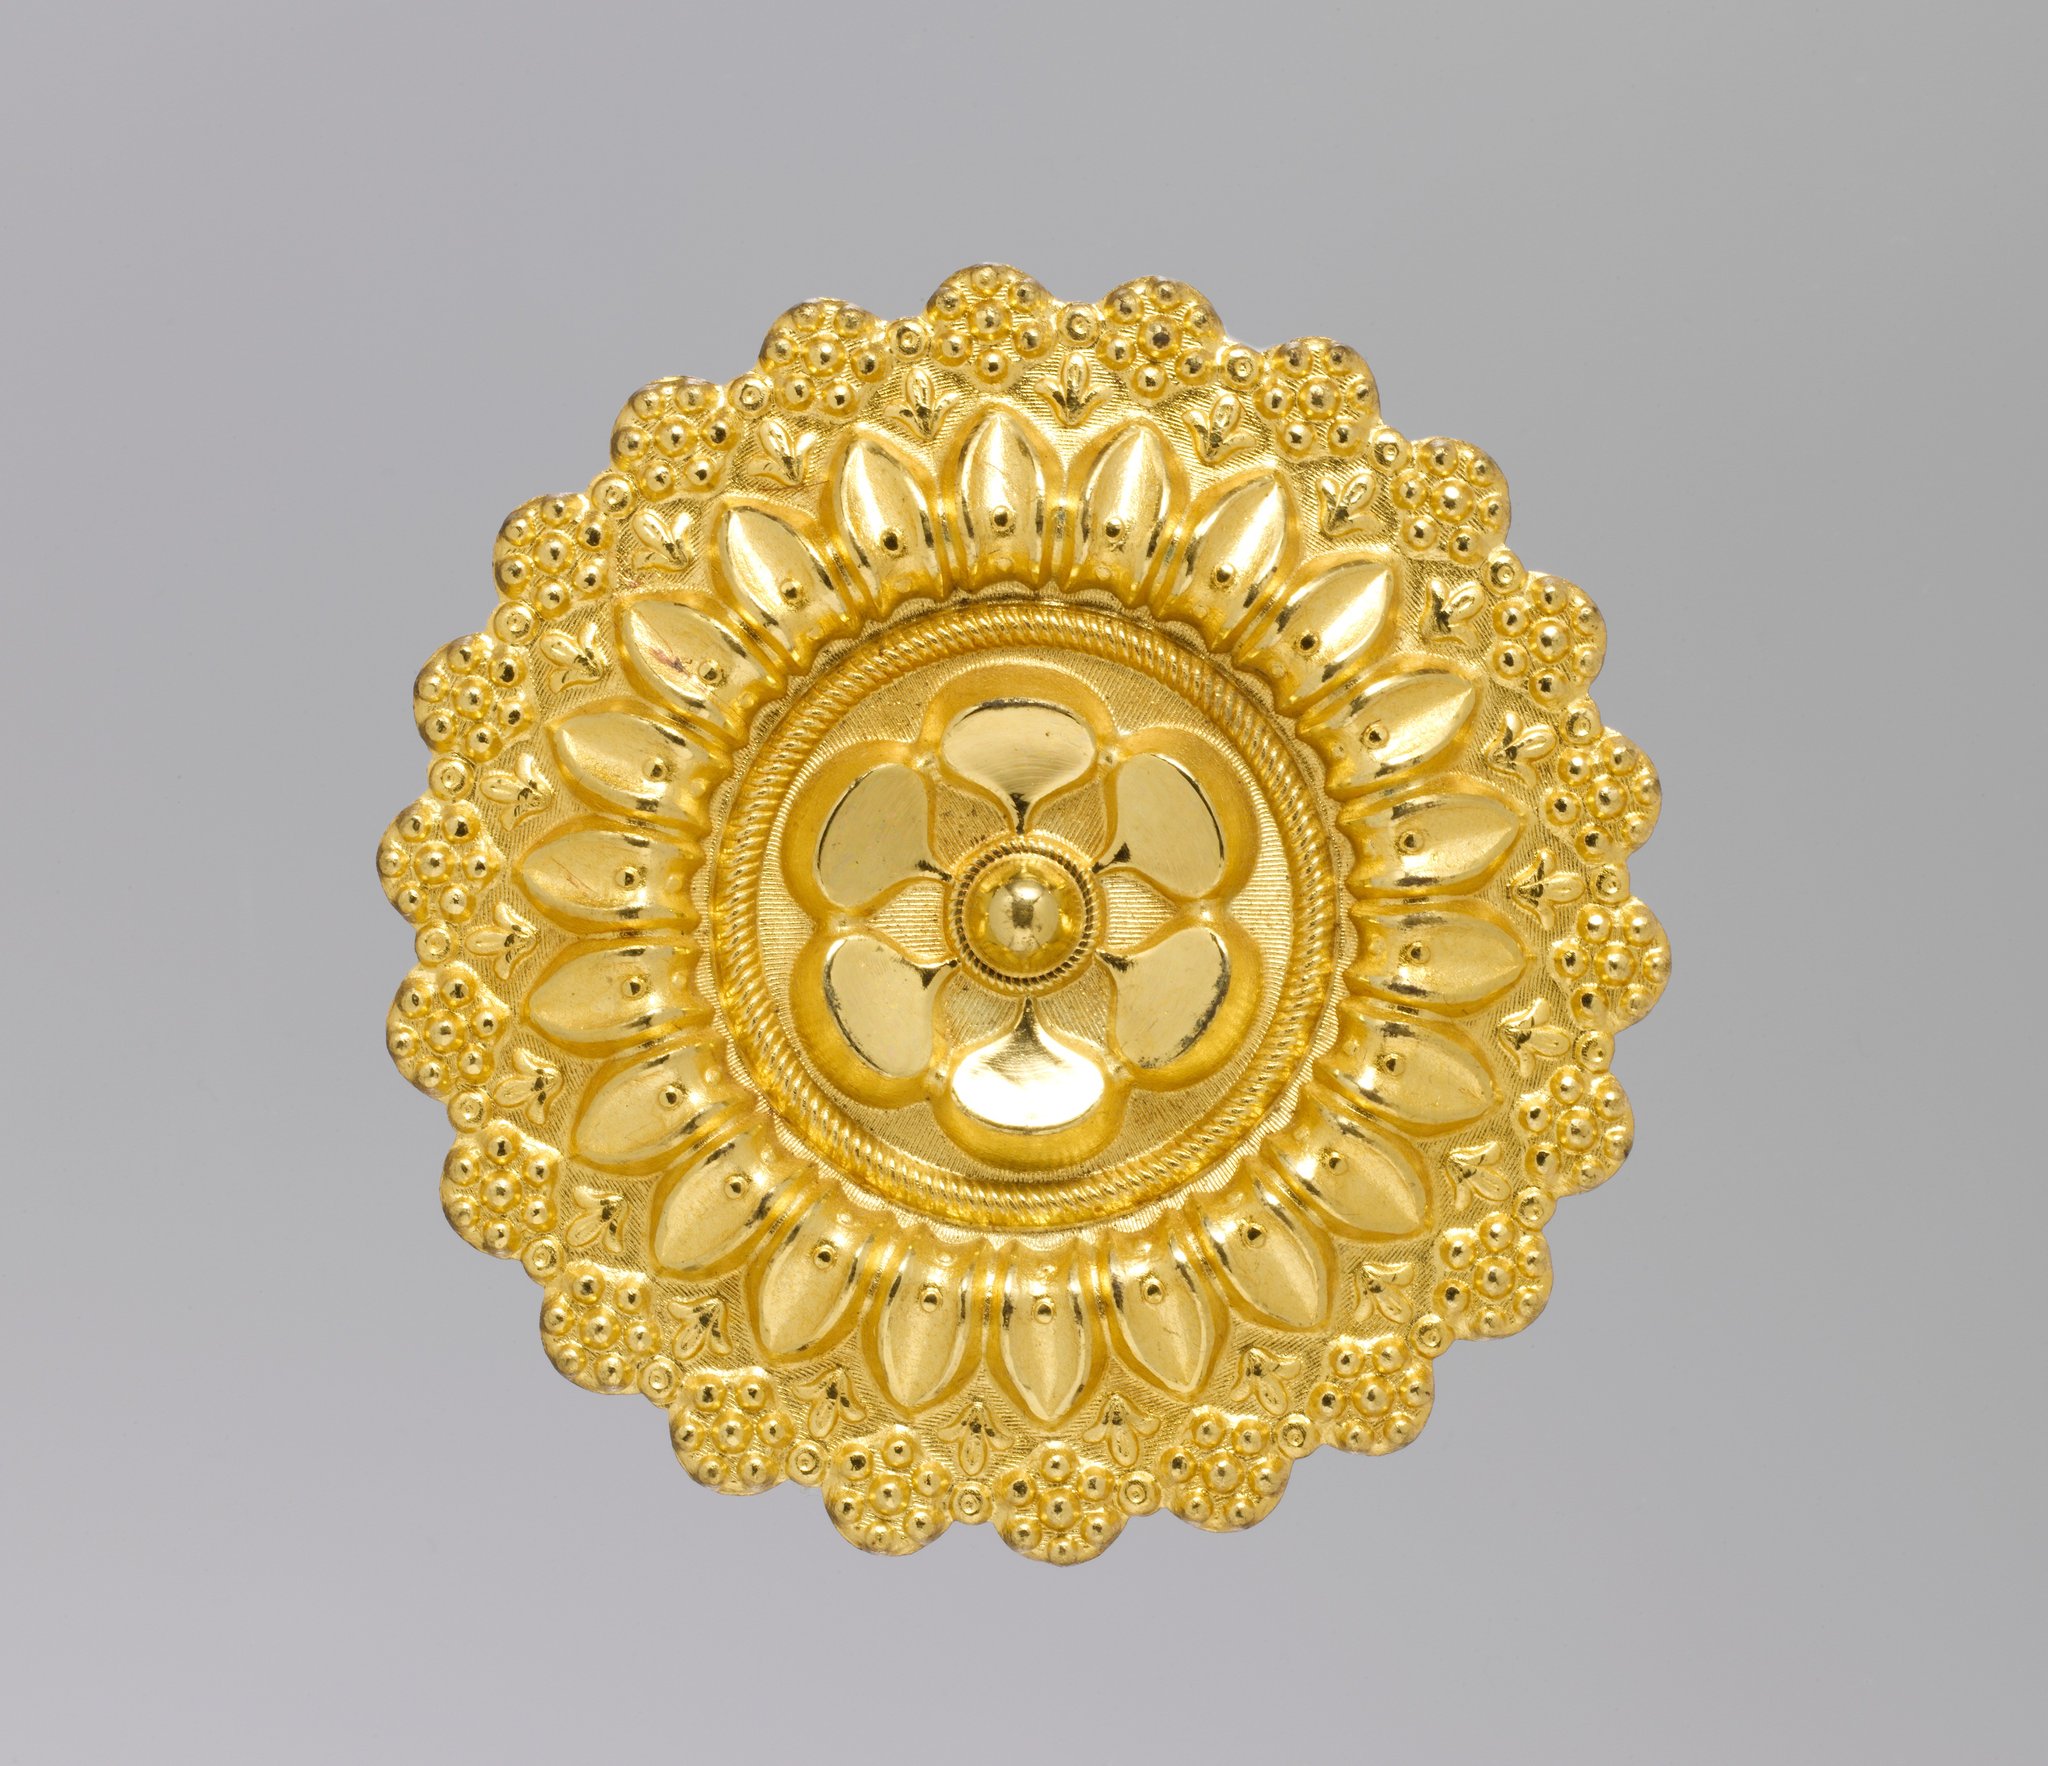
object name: curtain tieback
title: Curtain tie-back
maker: henry kellam hancock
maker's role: retailer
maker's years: 1816-1851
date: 1810-1830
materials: brass, lacquer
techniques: stamping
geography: france